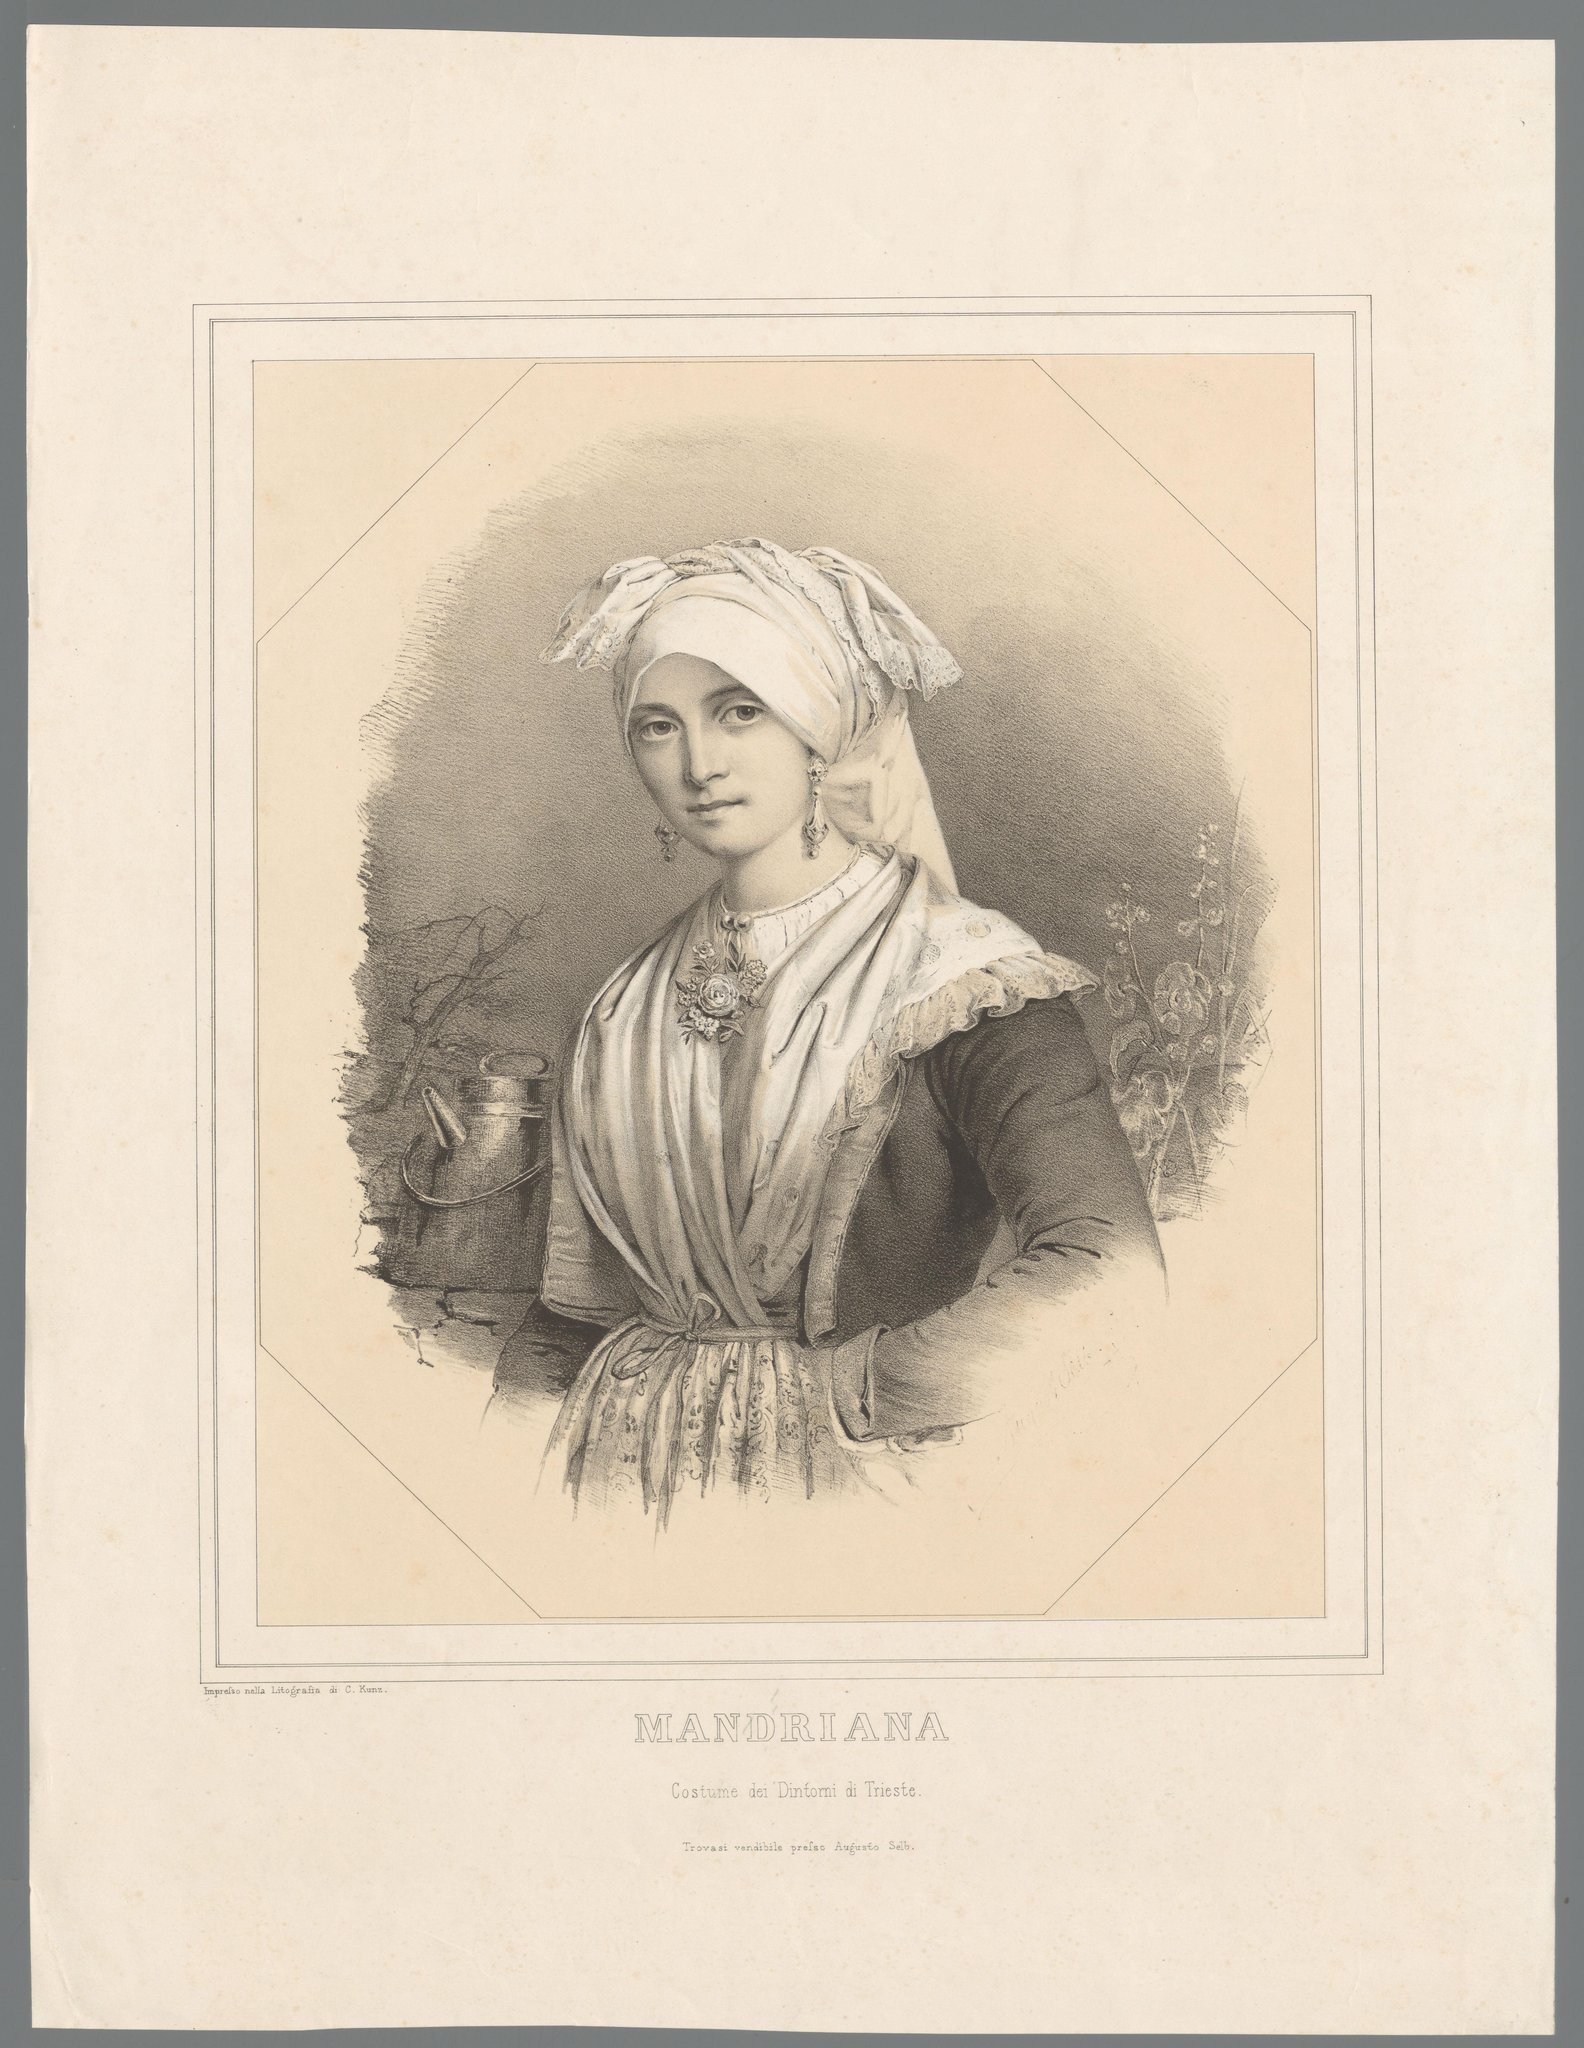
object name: print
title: Herderin in klederdracht uit de omgeving van Triëst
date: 1822-1859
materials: paper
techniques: tone lithography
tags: adult woman, herding, herdsman, herdswoman, shepherd, shepherdess, cowherd, etc., folk costume, regional costume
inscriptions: collector's mark: Lugt 2228